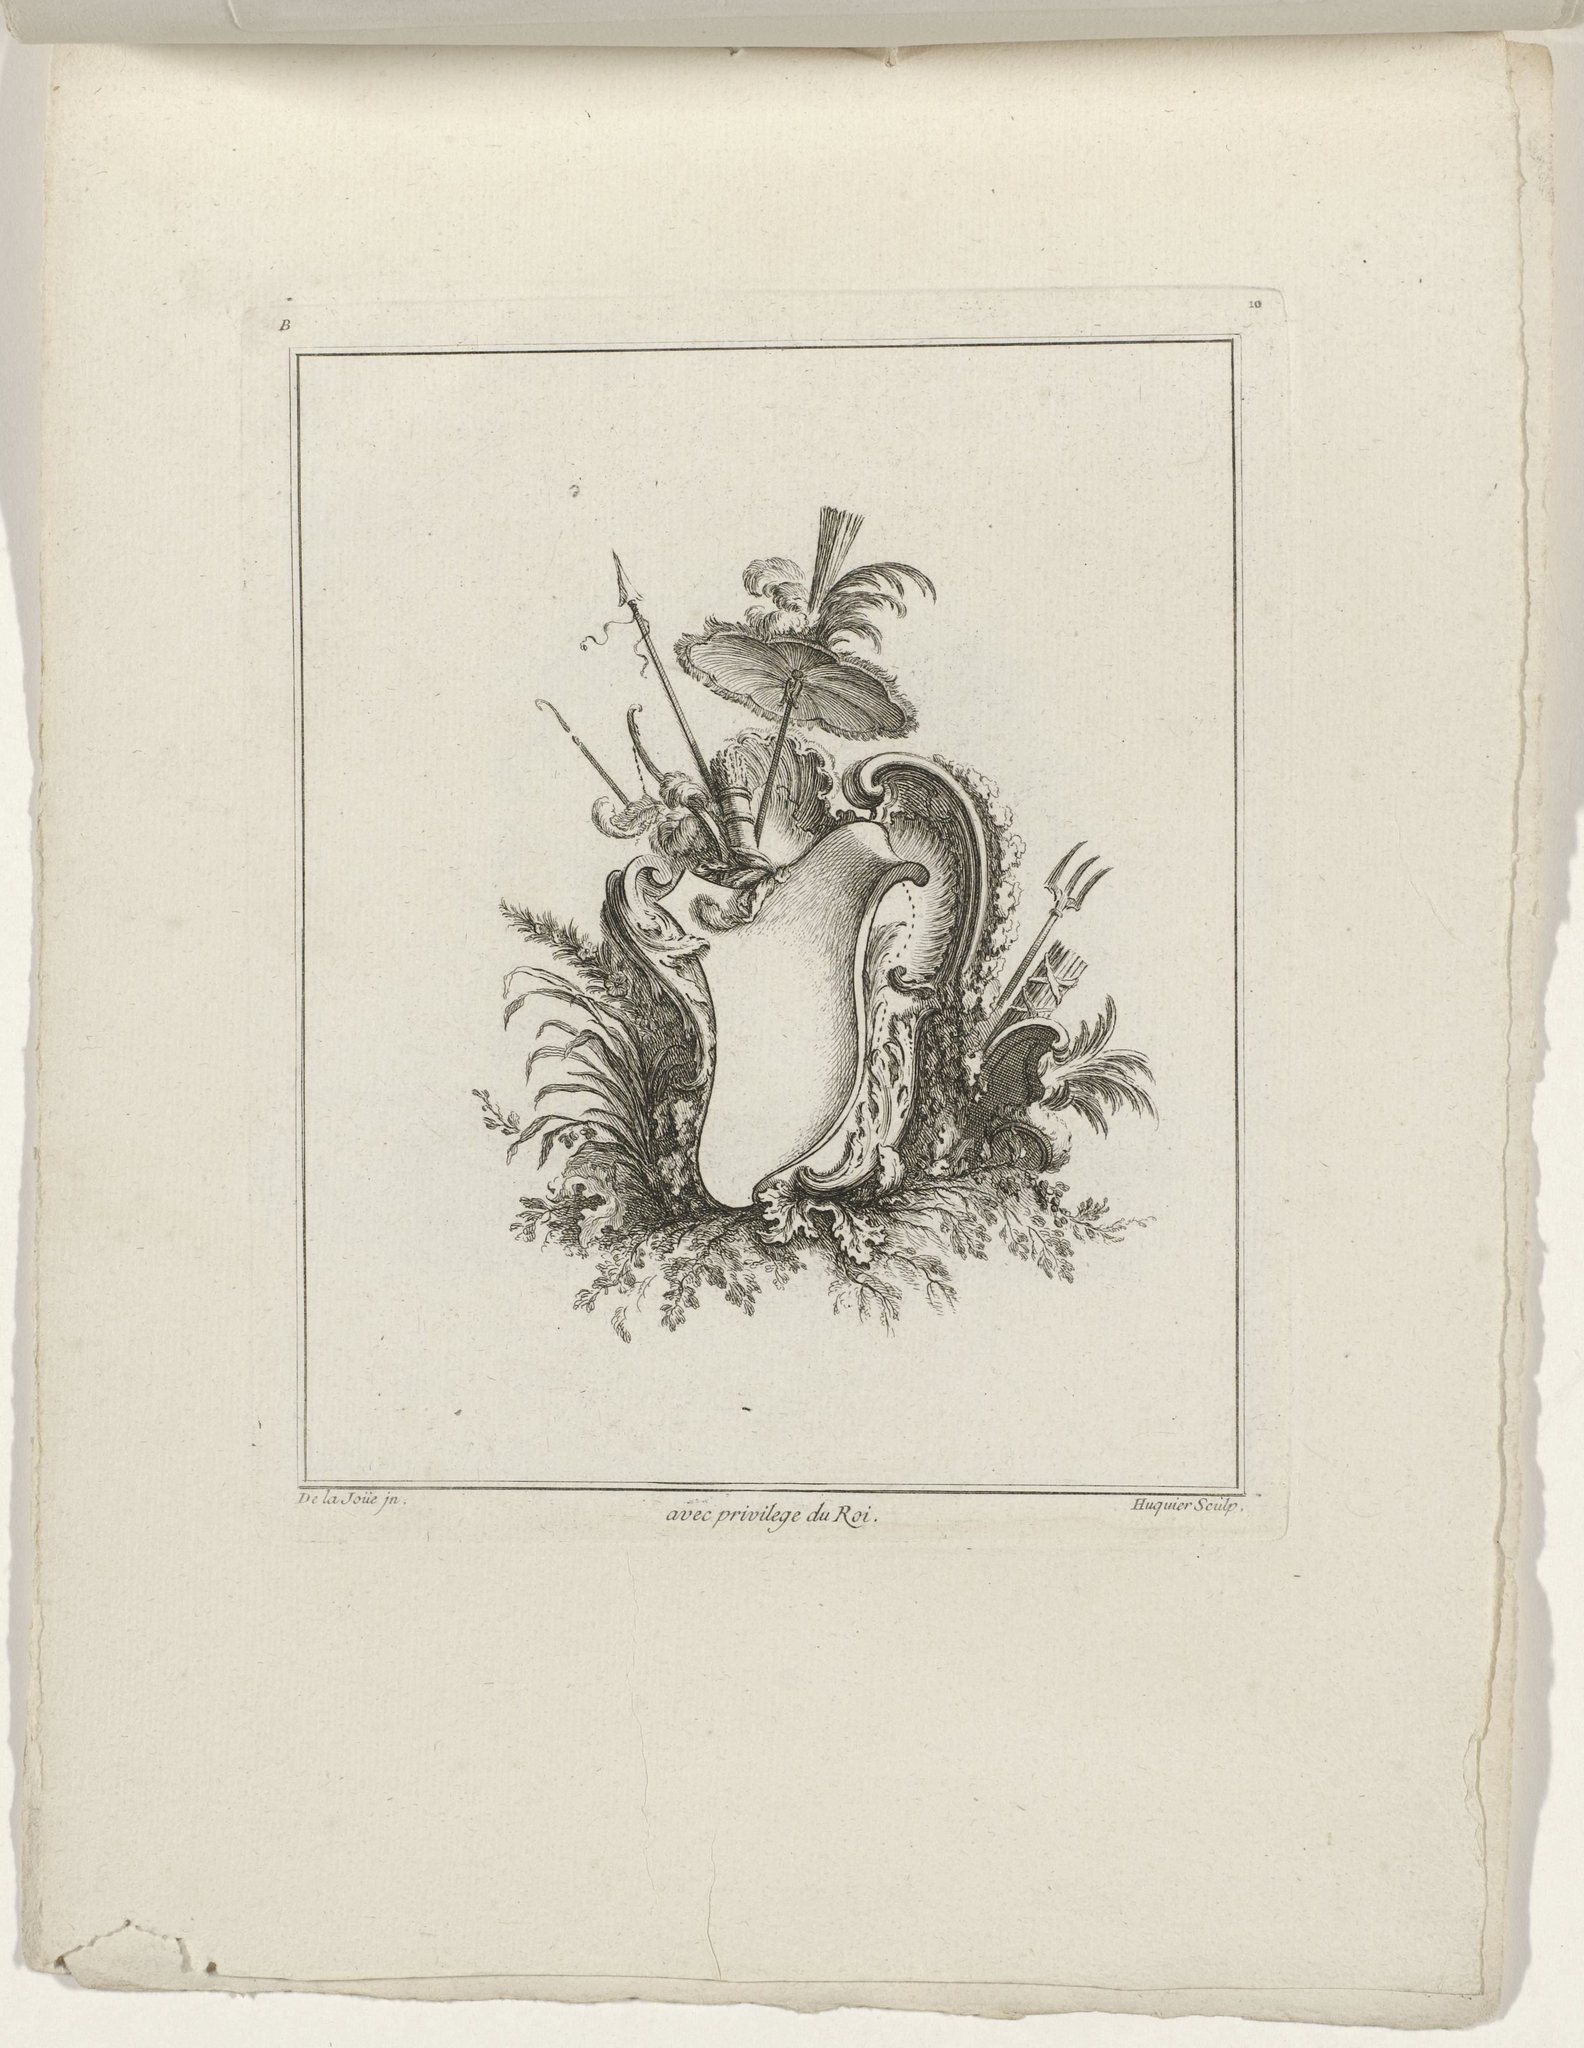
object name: ornament print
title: Second livre de cartouches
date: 1710-1772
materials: paper, fiber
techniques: engraving, etching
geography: paris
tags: fantasy ornament, ornament derived from plant forms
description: Cartouche bekroond met parasol omgeven door verschillende soorten bladeren, veren, een pijl en boog, een speer, een drietand en een roedenbundel. Onderdeel van een reeks van twaalf genummerde ornamentprenten.